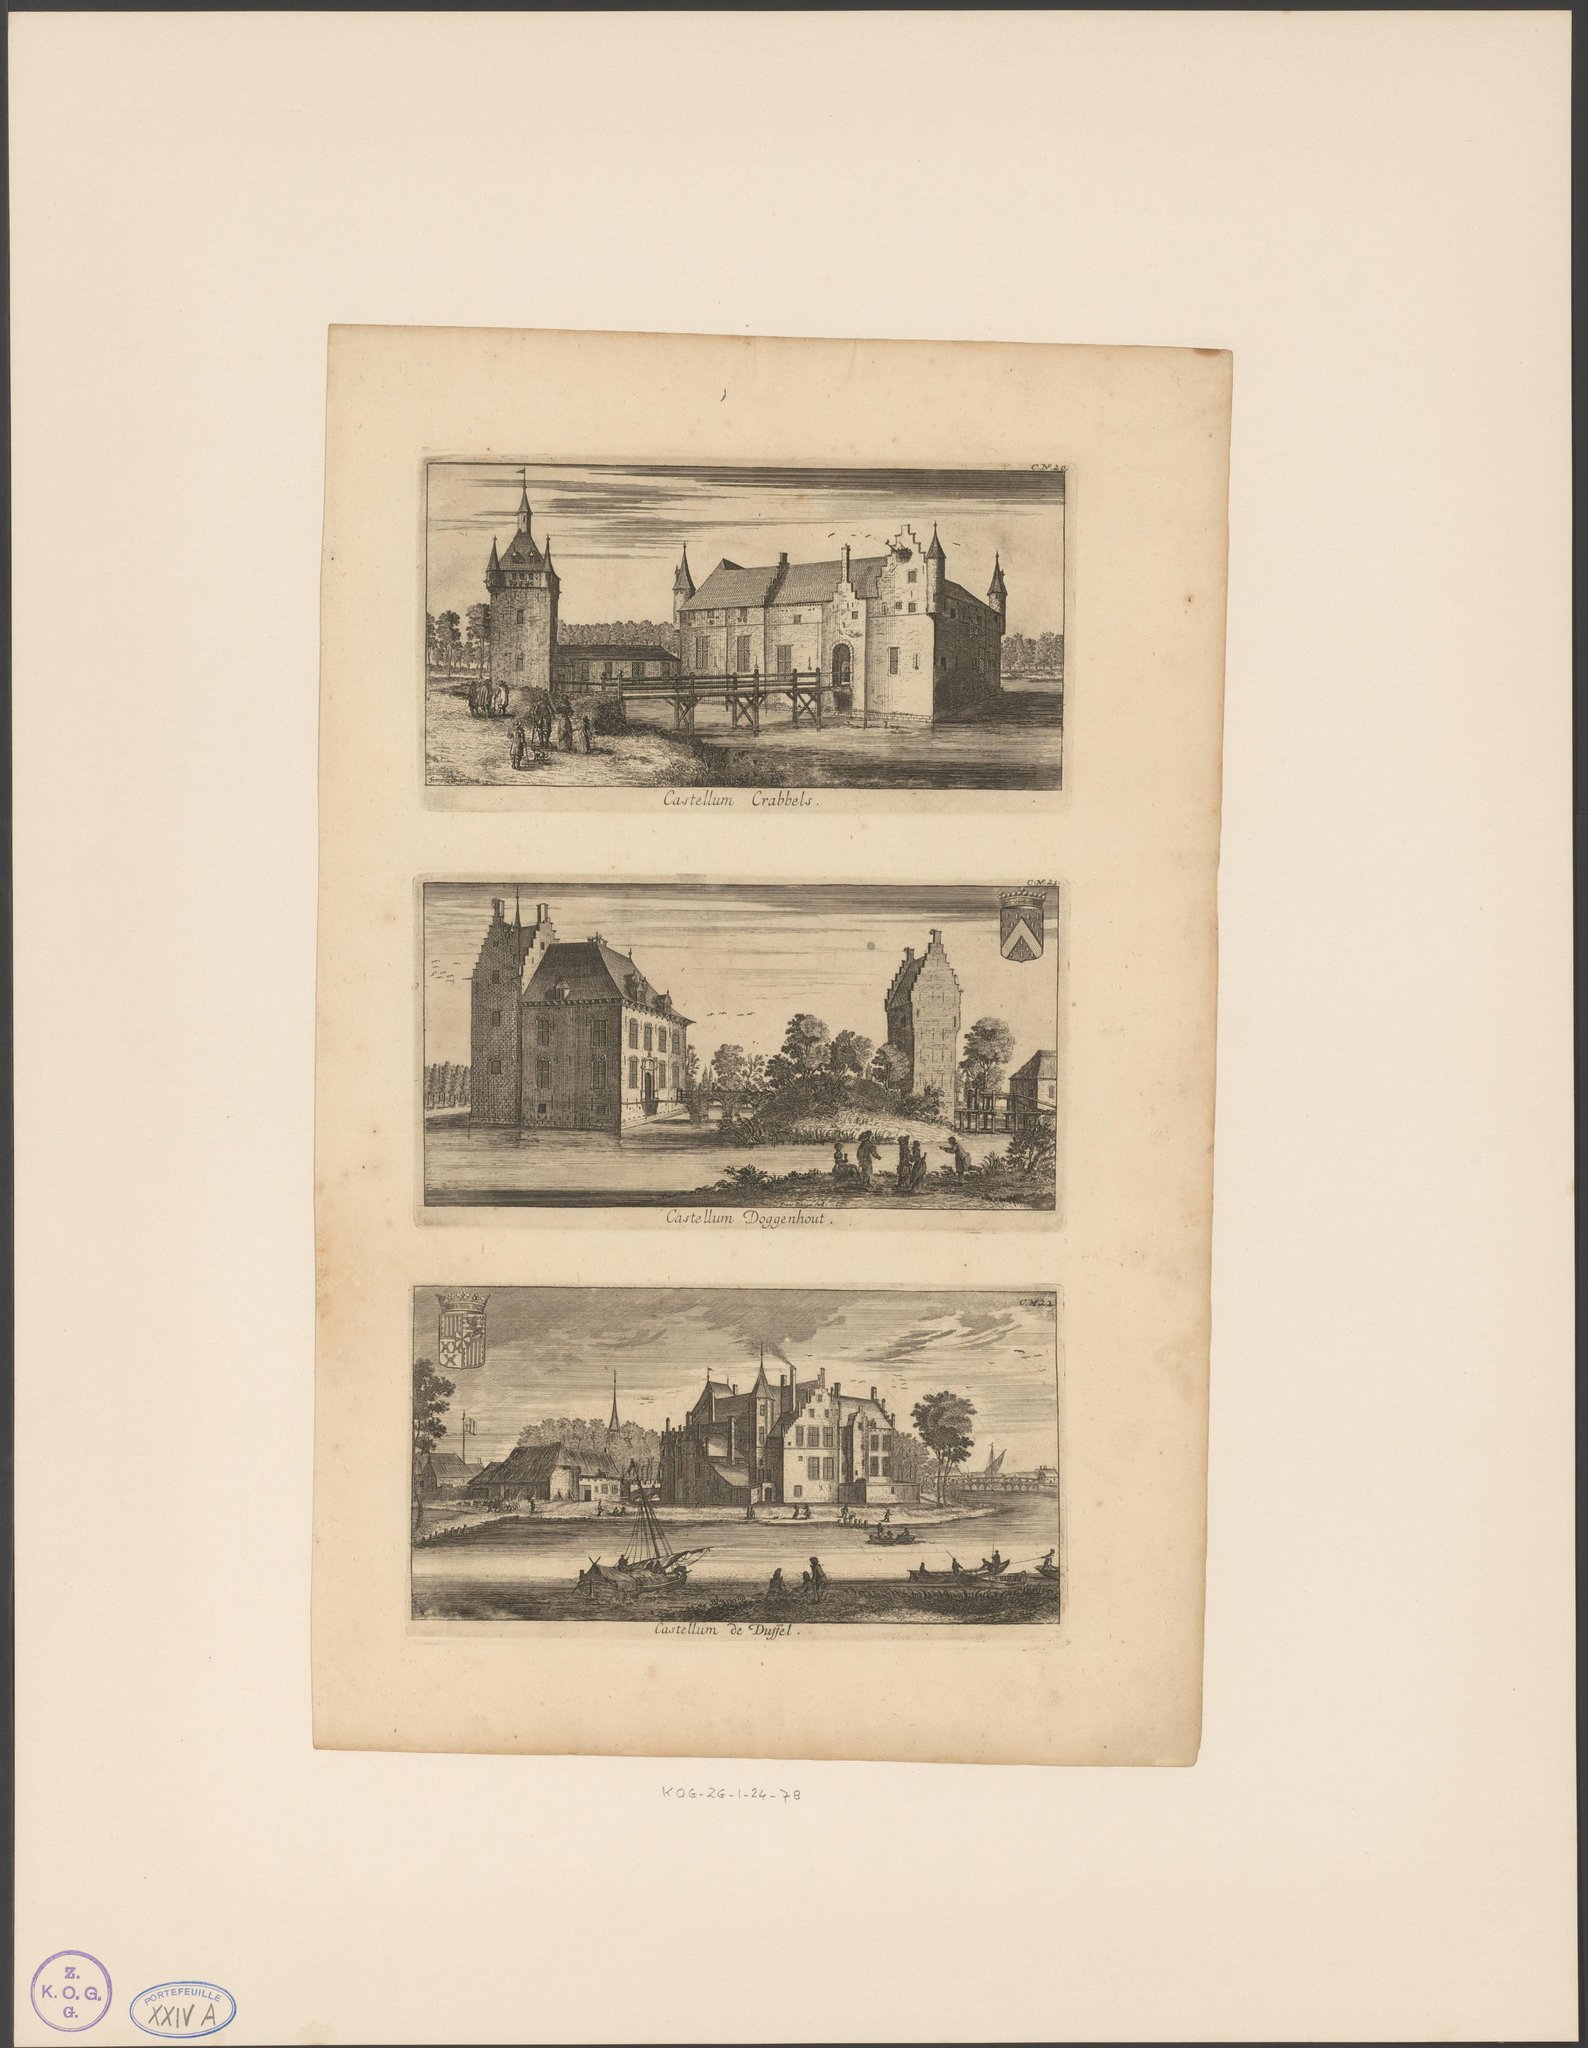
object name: print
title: Castellum de Duffel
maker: franz ertinger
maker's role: print maker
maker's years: 1640-1710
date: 1750-1799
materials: paper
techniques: engraving, etching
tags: castle, armorial bearing, heraldry, antwerp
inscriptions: collector's mark: Lugt 1641, stamp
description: Van deze prenten bestaan in ieder geval vijf staten. De eerste staat is gebruikt in Jacques le Roys 'Notitia Marchionatus Sacri Romani Imperii (…)' uit 1678. De tweede en derde staat komt voor in latere uitgaven van Le Roys werk (tweede: 1692, 1699, 1705, 1706; derde: 1730). De vierde staat is gebruikt in Philippe de Cantillons 'Delices du Brabant et de ses campagnes (…)' (1757). De huidige (vijfde) staat komt voor in: Cantillon, Philippe de. Vermakelykheden van Brabant, en deszelfs onderhoorige landen (…). 4 dln. 1e druk. Amsterdam: David Weege, 1770, dl. 3. En in: Cantillon, Philippe de. Vermakelykheden van Brabant, en deszelfs onderhoorige landen (…). 4 dln. 2e druk. Utrecht: Gijsbert Tieme van Paddenburg en Justus Visch, 1777, dl. 3.